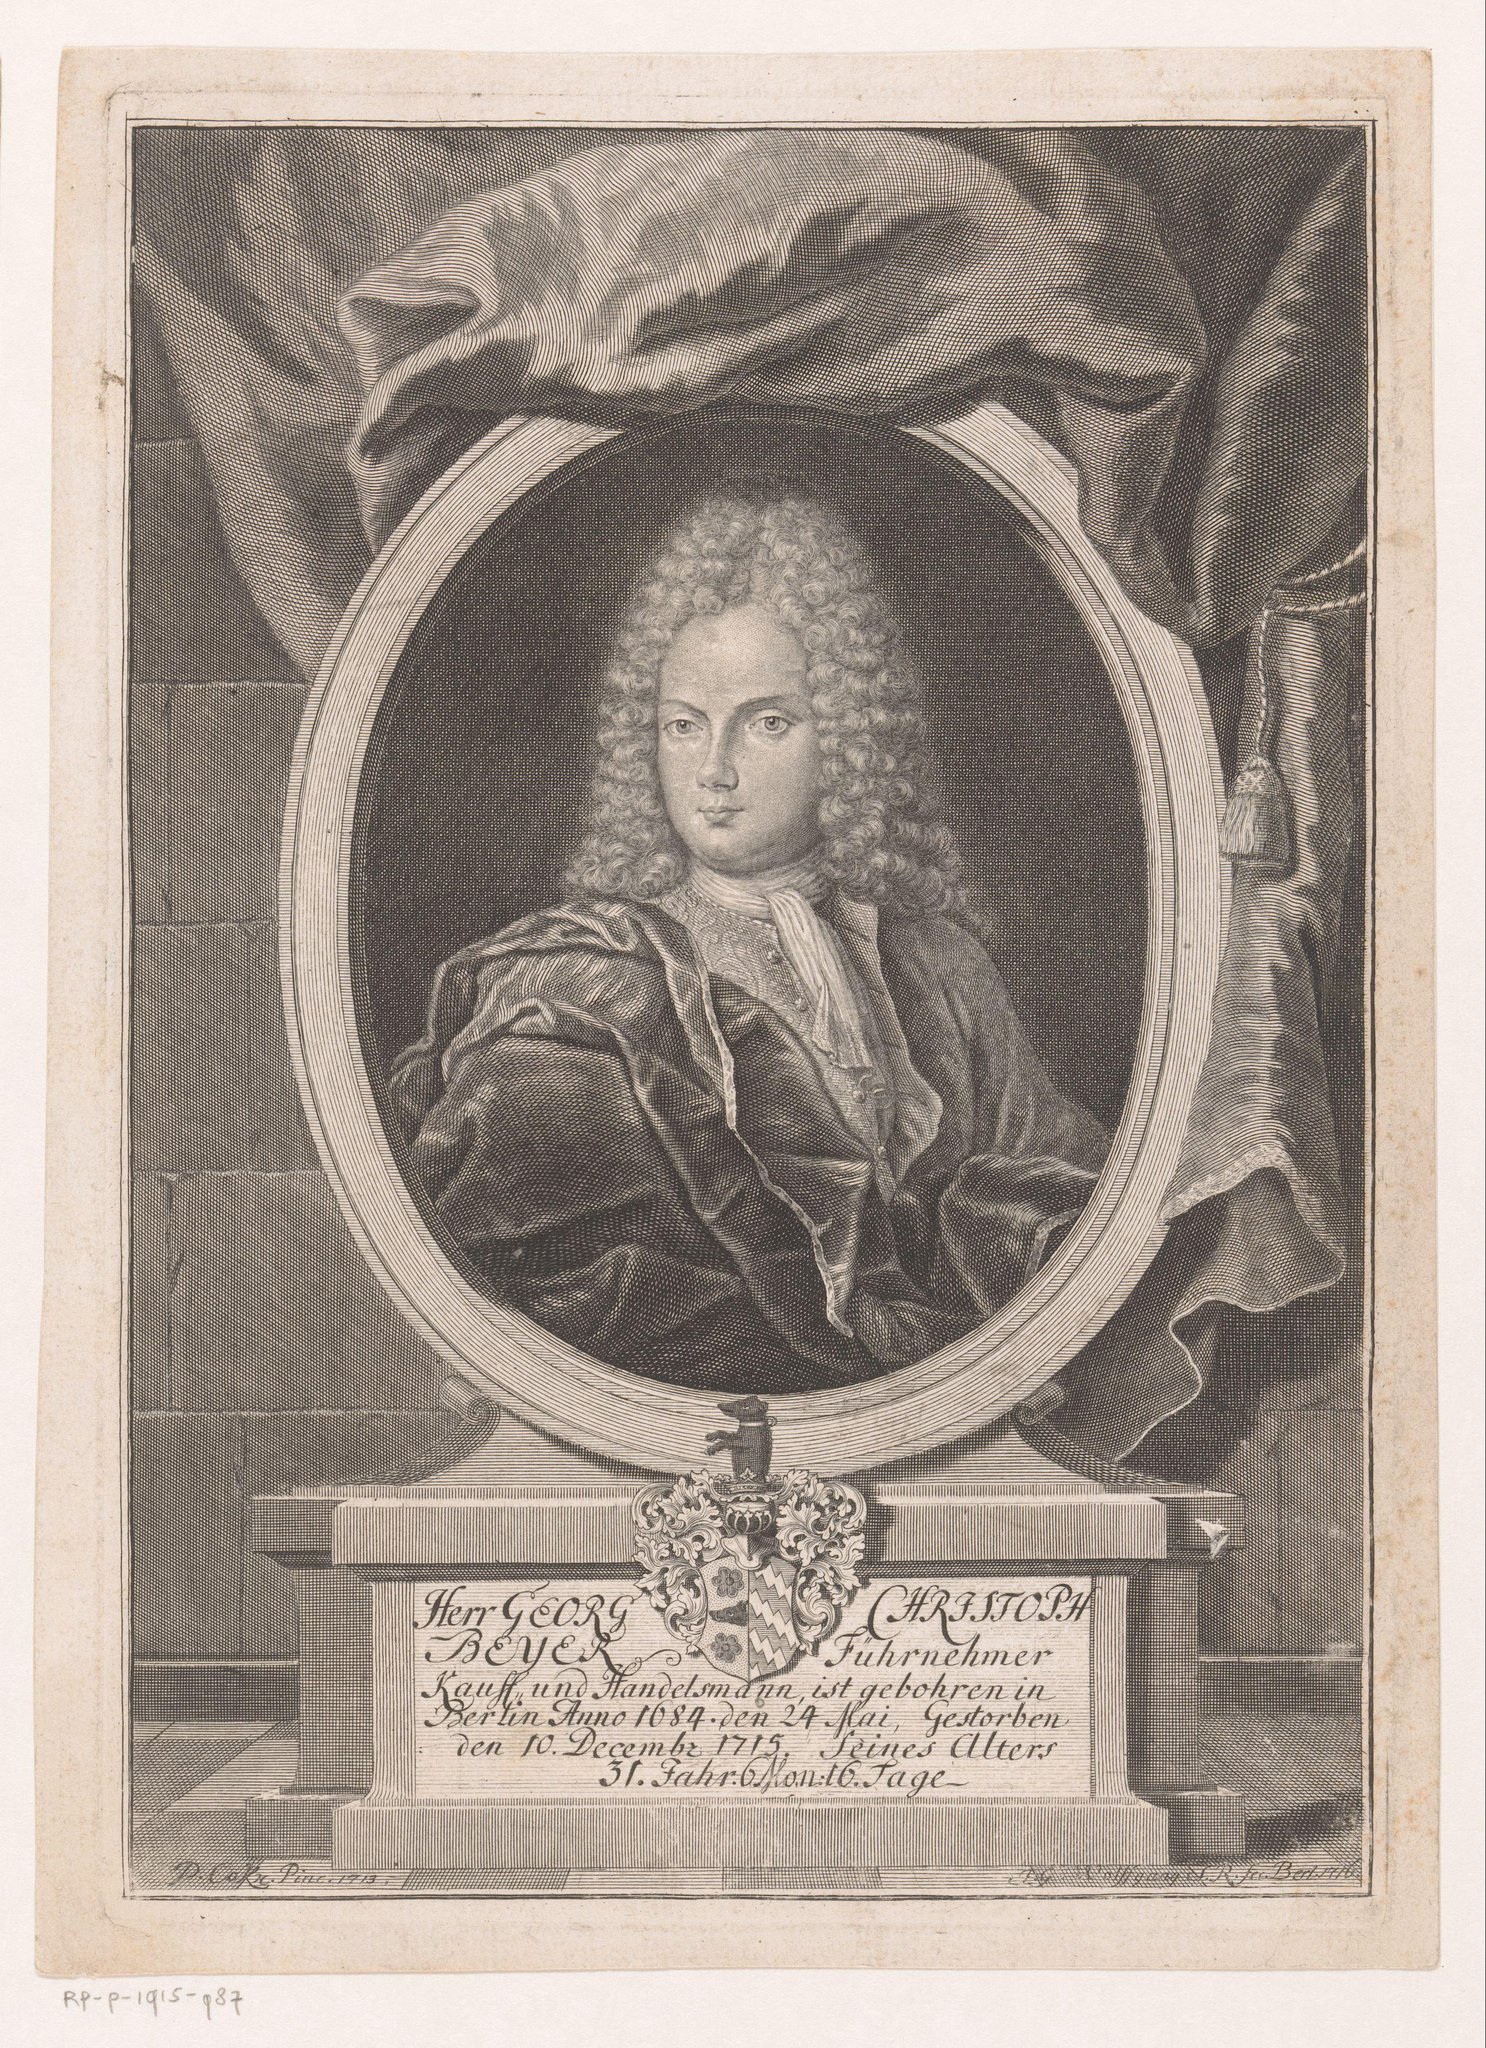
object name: print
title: Portret van Georg Christoph Beyer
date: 1716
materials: paper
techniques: engraving, etching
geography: berlin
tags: historical persons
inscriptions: collector's mark: Lugt 2228